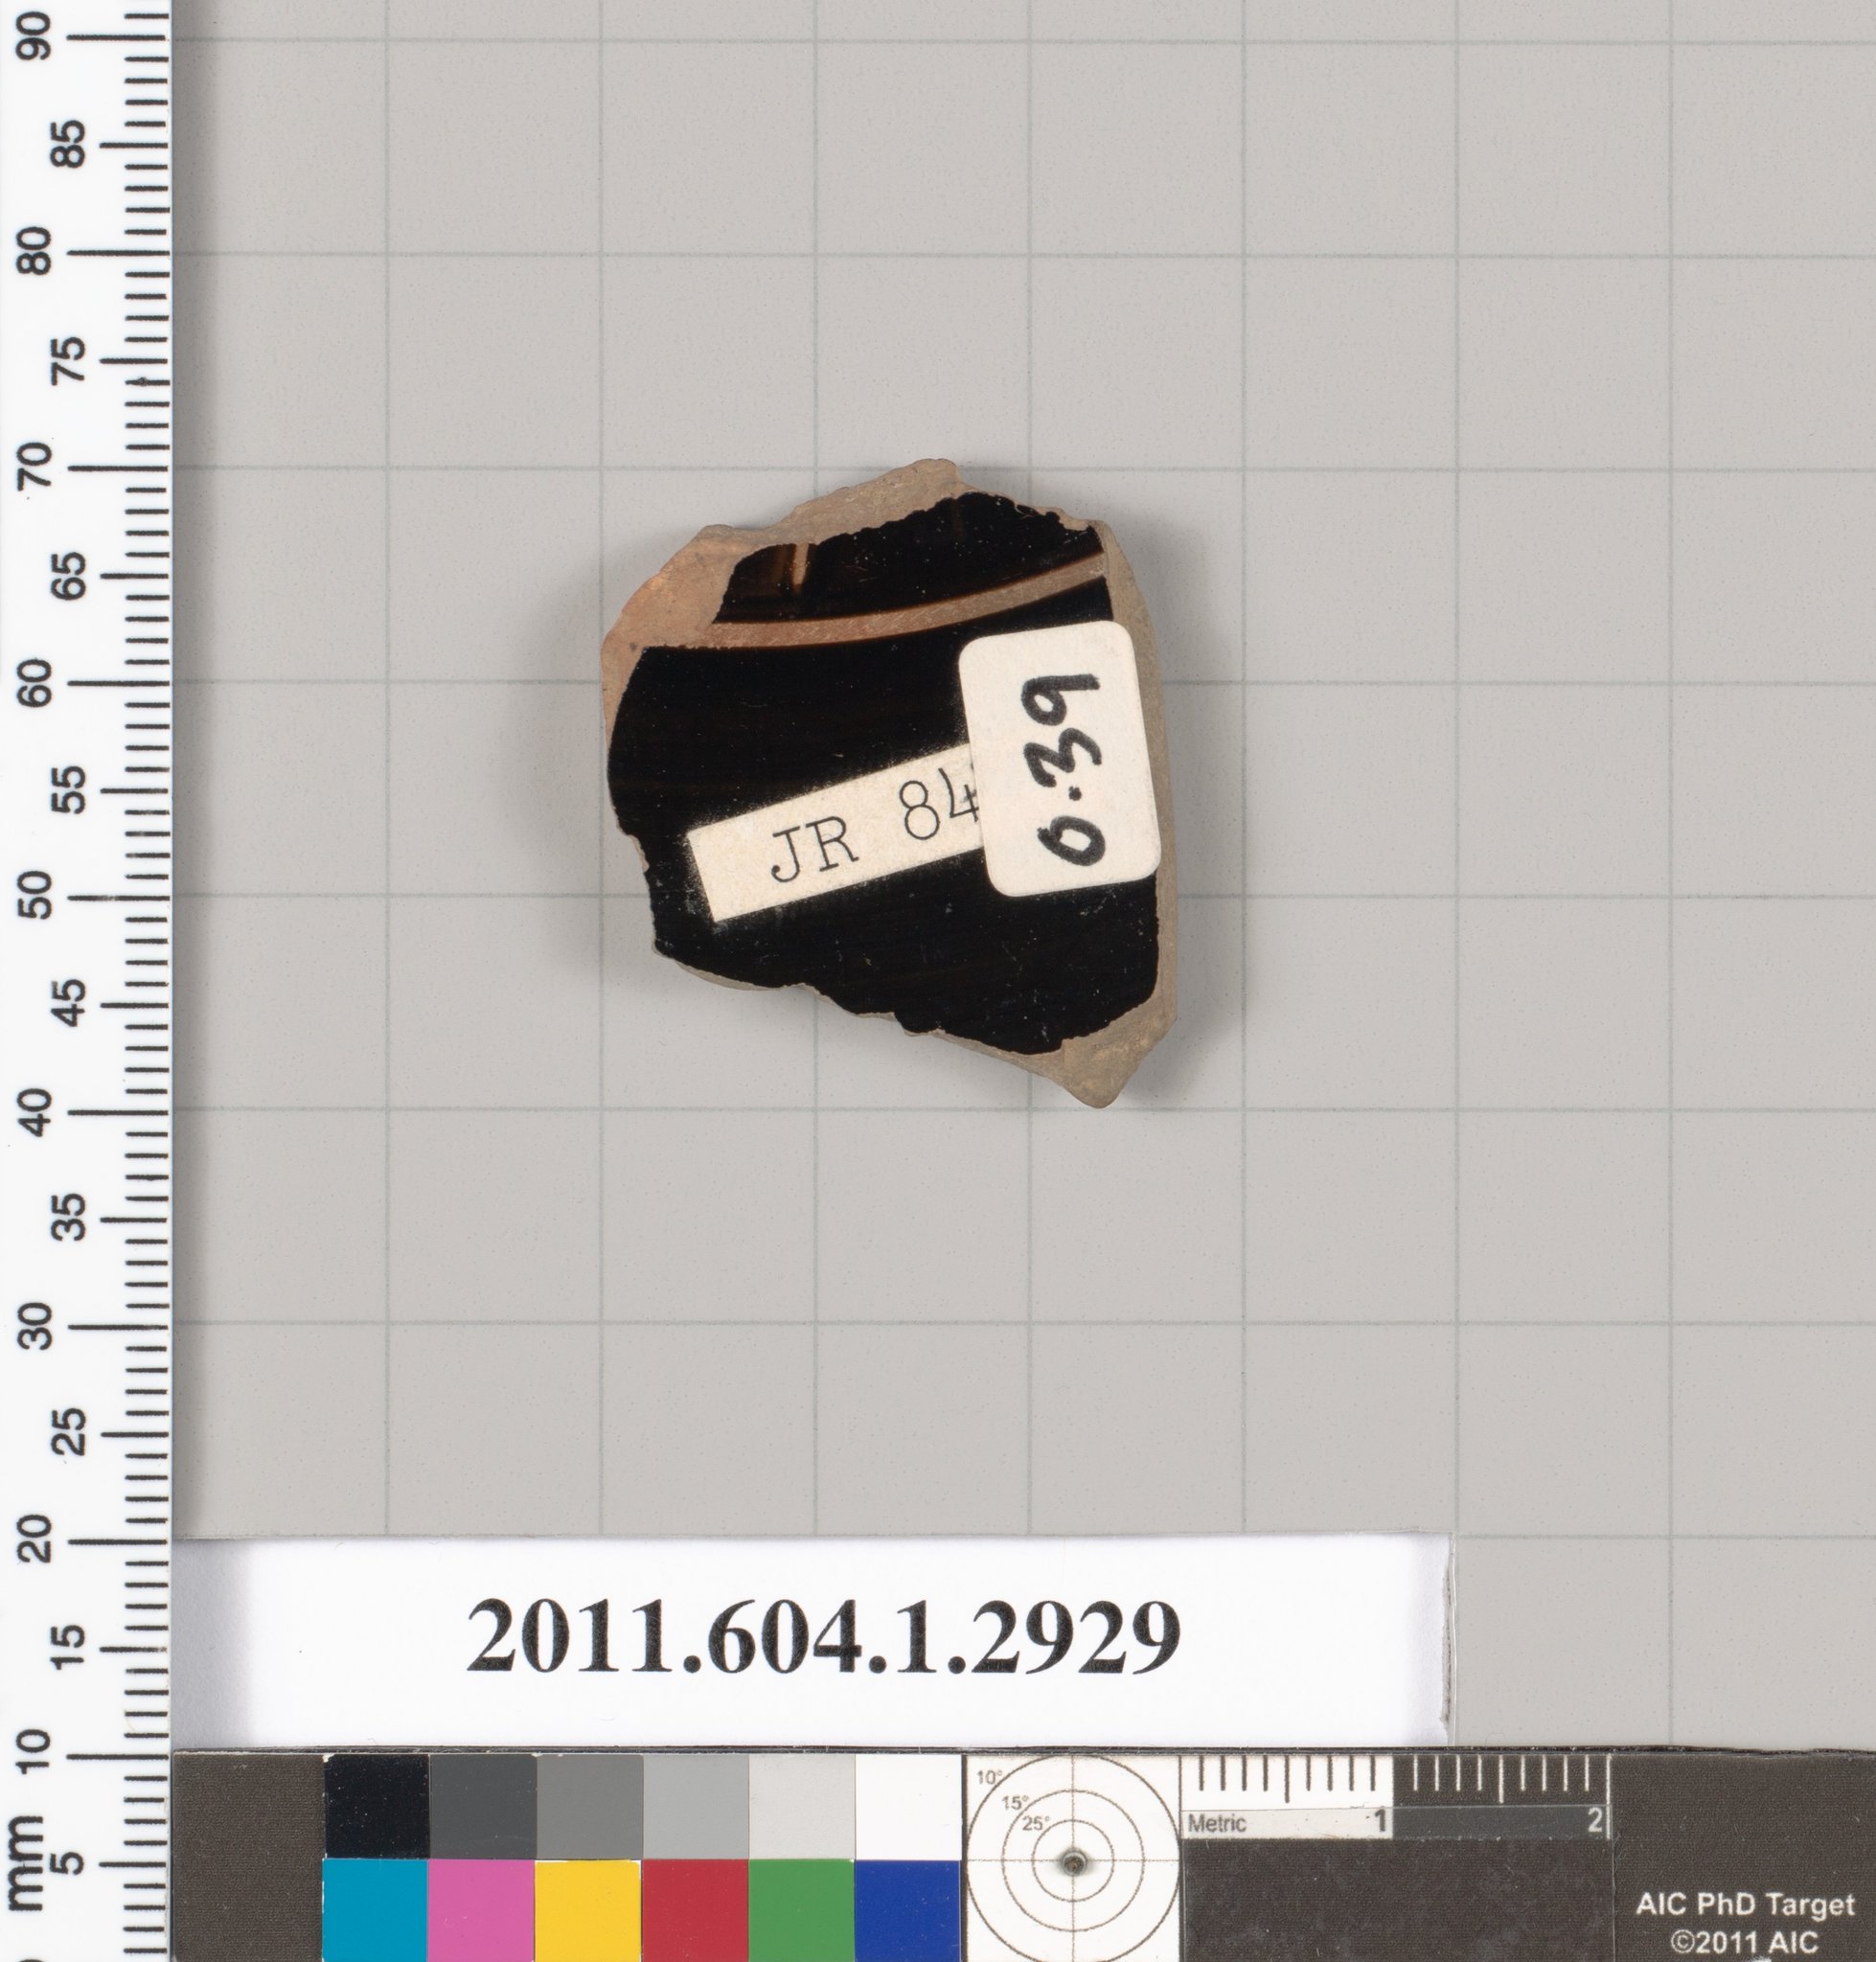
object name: kylix fragment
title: Terracotta fragment of a kylix (drinking cup)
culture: greek, attic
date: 600-401 BCE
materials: terracotta